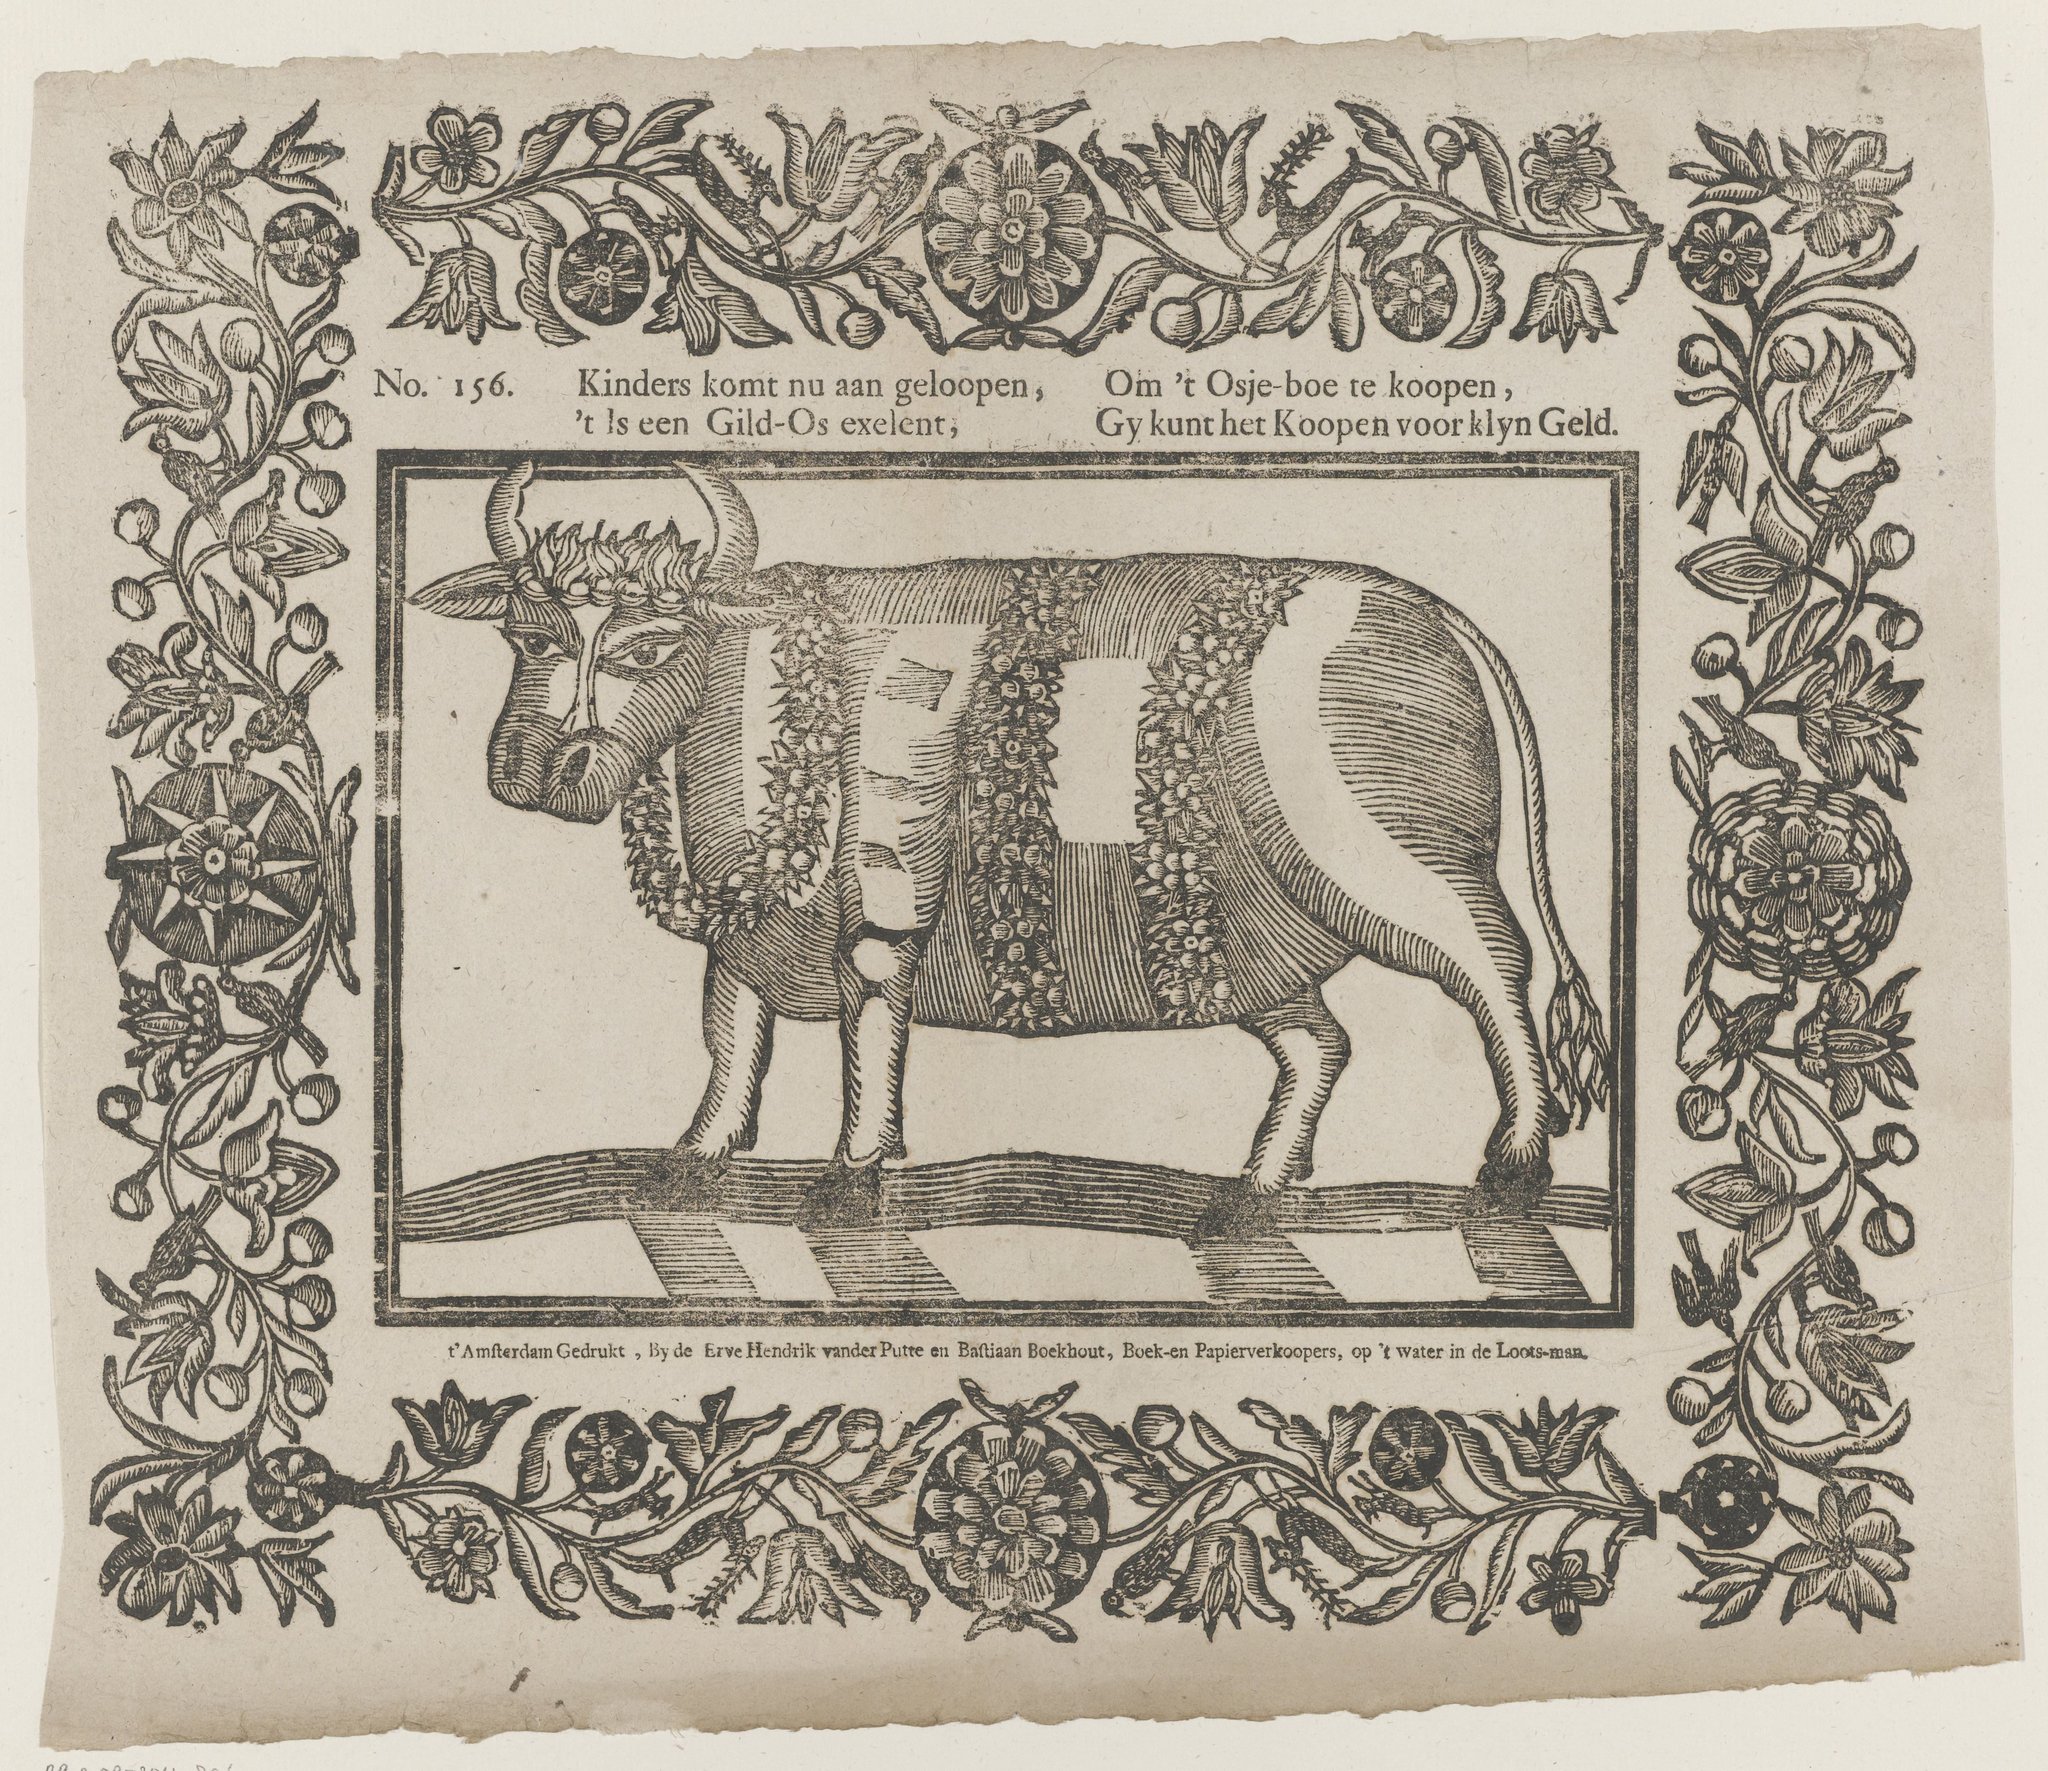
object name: popular print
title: Kinders komt nu aan geloopen / Om 't osje-boe te koopen / 't is een gild-os exelent, / Gy kunt het koopen voor klyn geld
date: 1767-1793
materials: paper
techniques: letterpress printing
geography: amsterdam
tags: floral interlace ~ ornament, prize-ox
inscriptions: collector's mark: Lugt 2760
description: Blad met een grote voorstelling van een gilde-os (ook kermisos of prijsos genoemd), versierd met bloemenkransen. De voorstelling is gevat in een sierlijst met ranken, dieren en bloemen. Genummerd linksboven: No. 156.